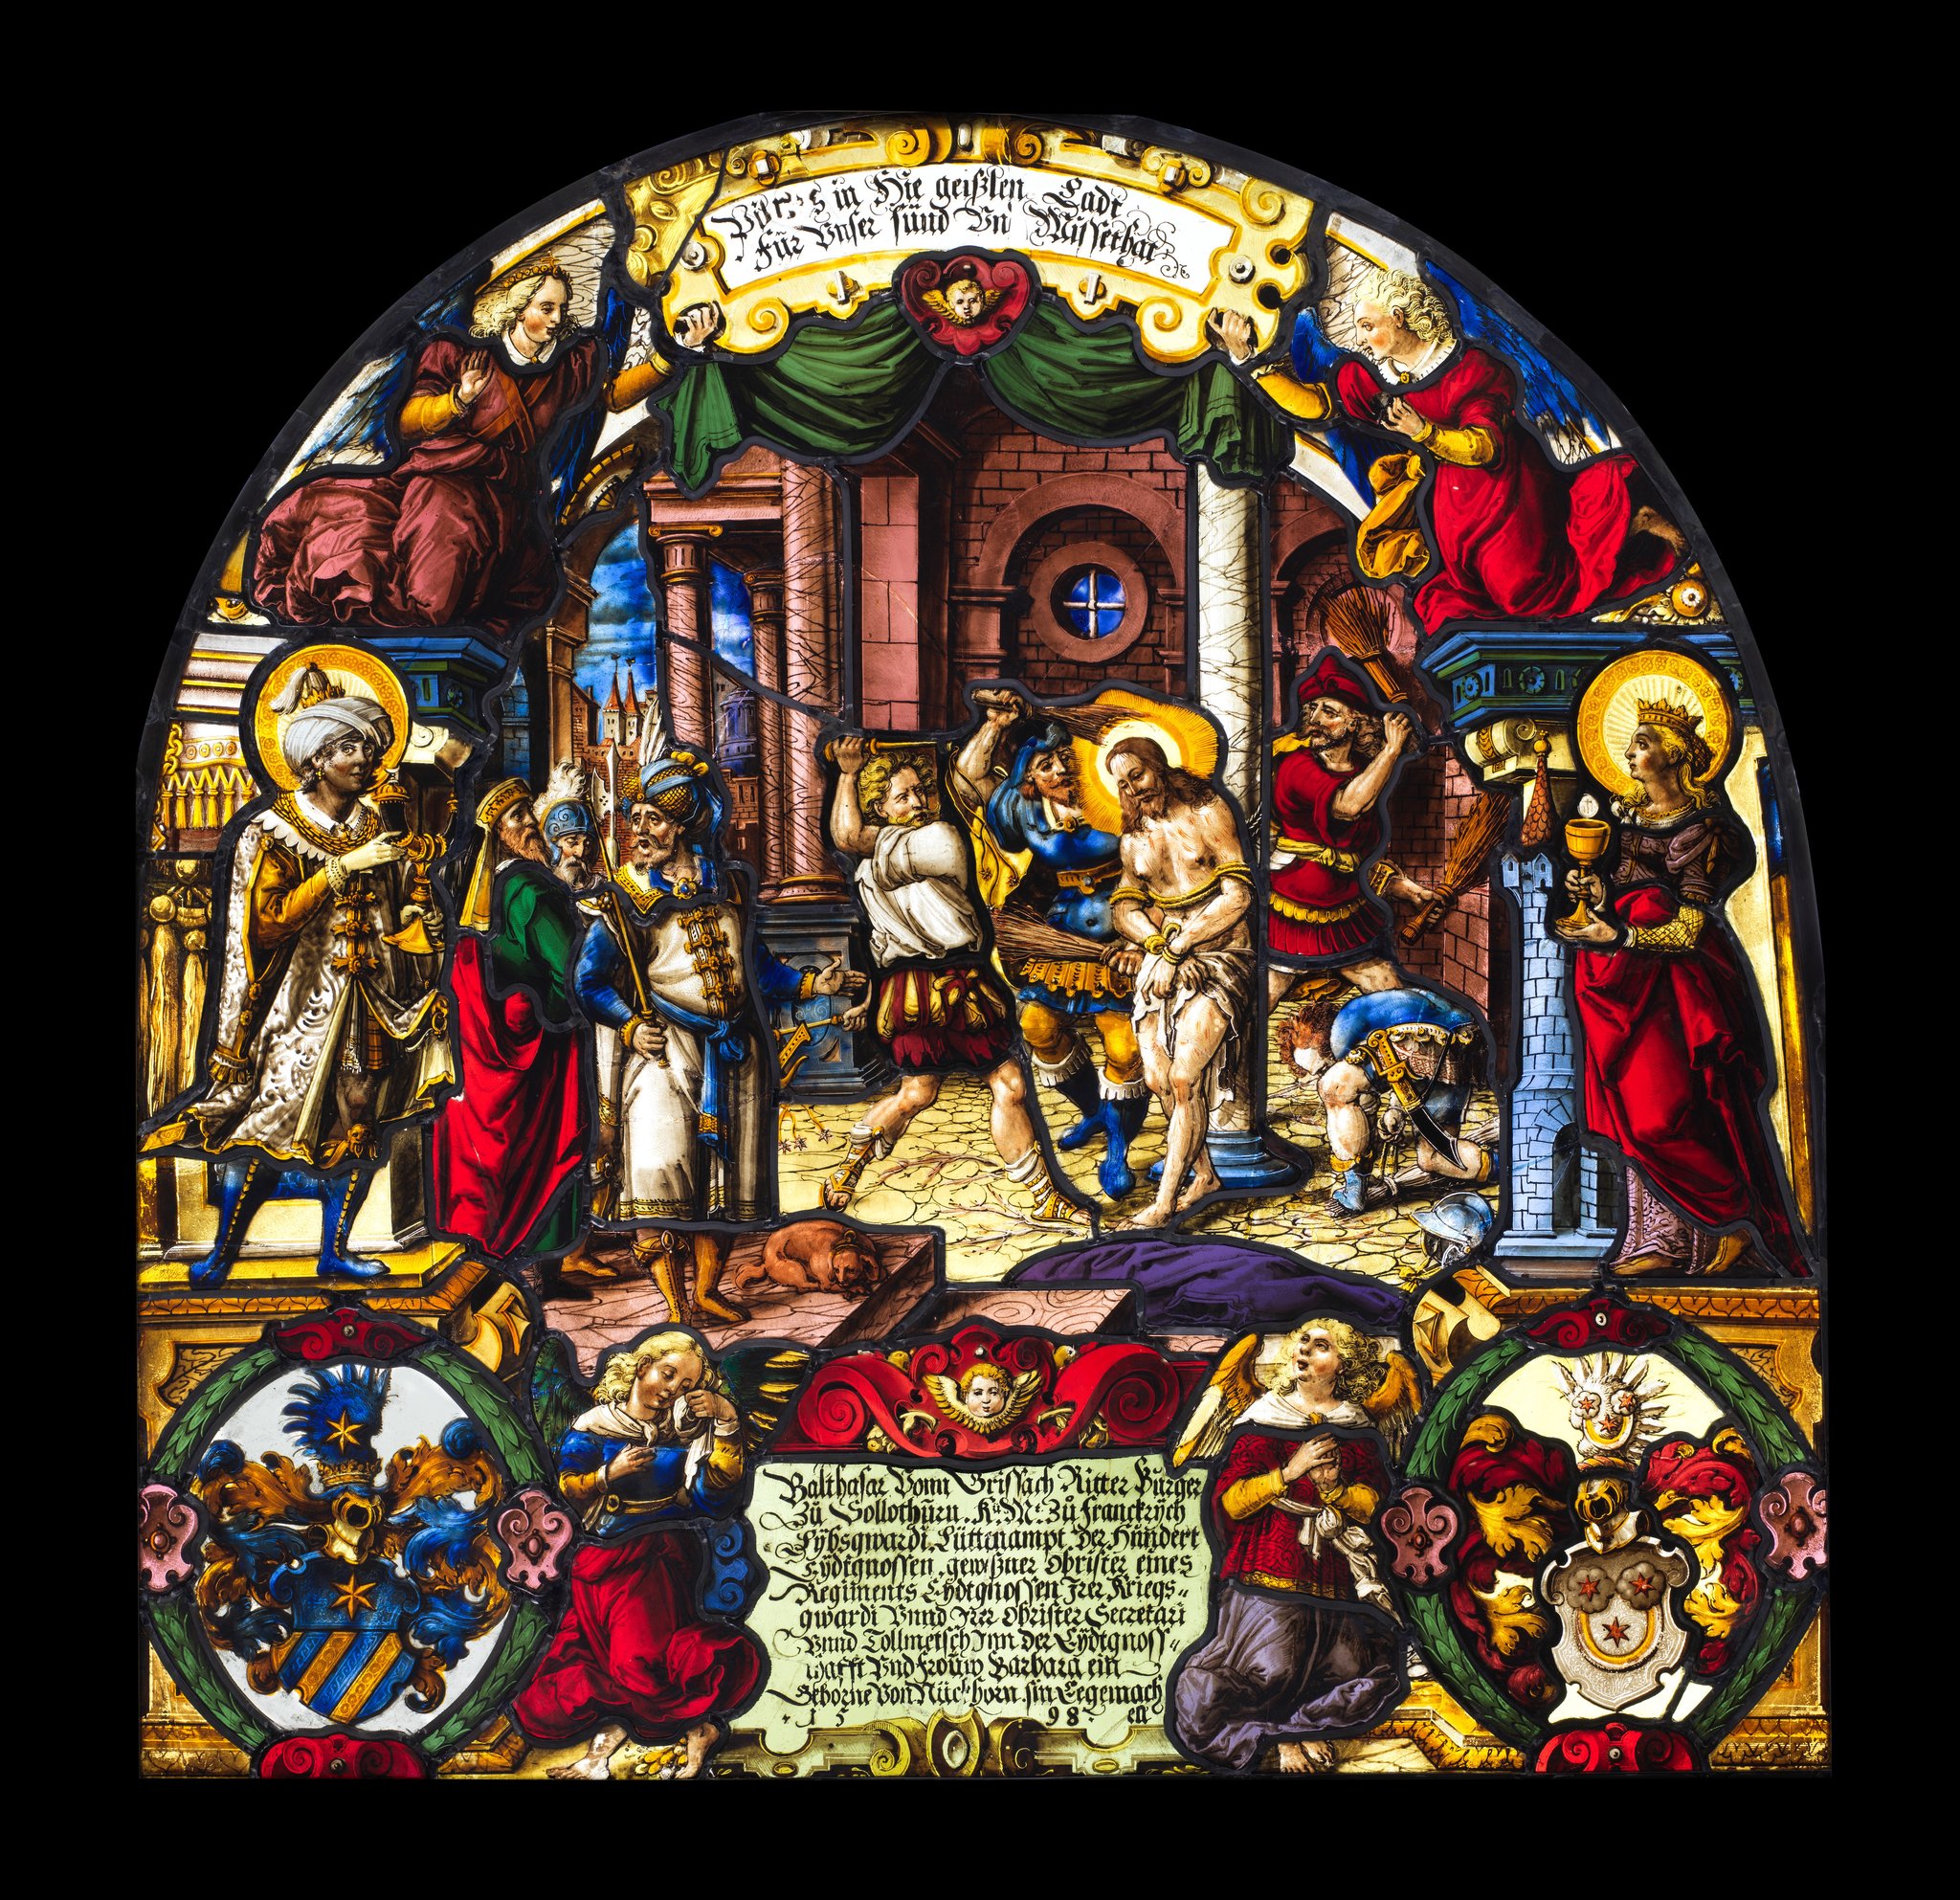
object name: panel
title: The Flagellation, Christ at the Column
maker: franz fallenter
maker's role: artist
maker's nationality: german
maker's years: 1550-1616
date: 1598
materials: glass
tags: suffering,men,christ